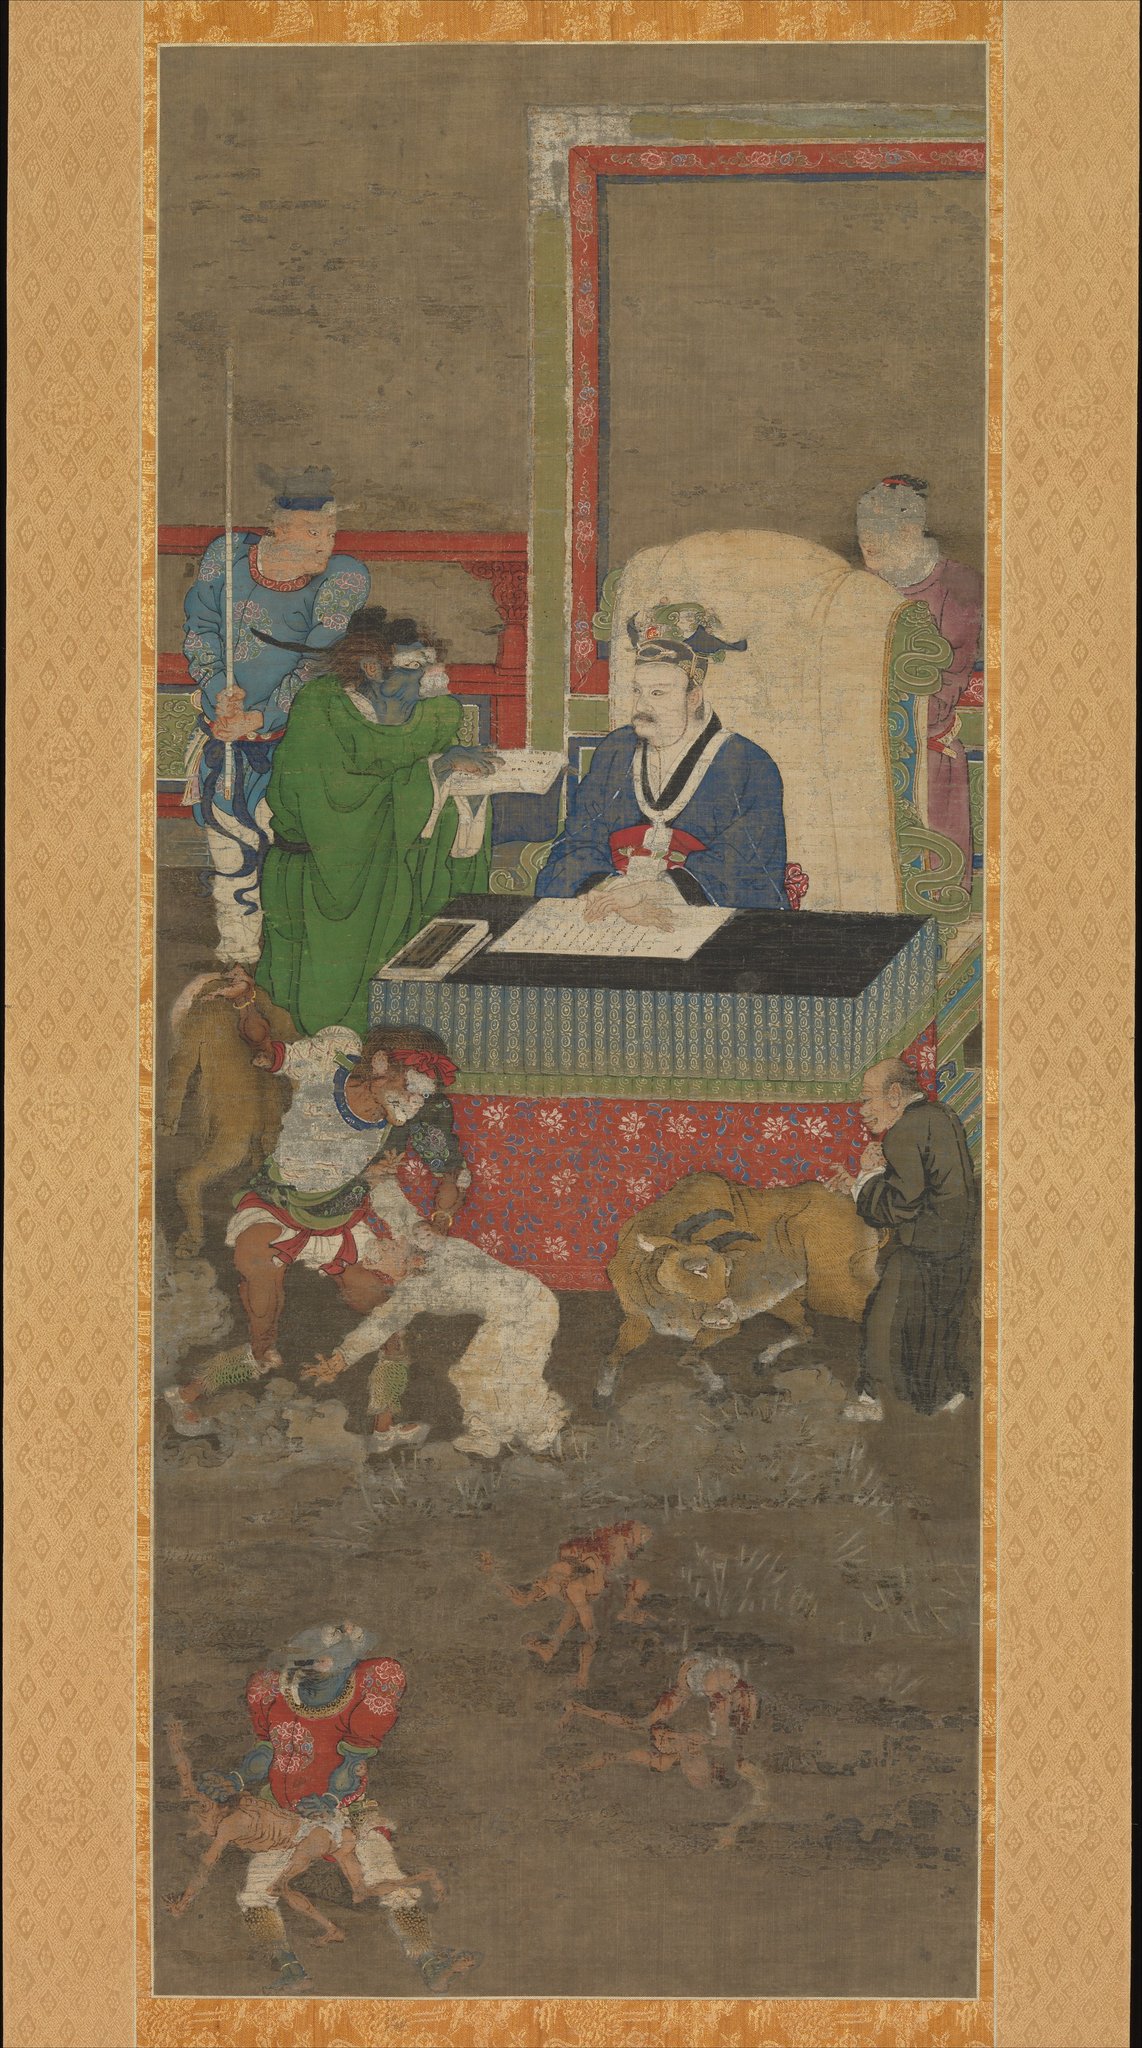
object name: hanging scroll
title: Ten Kings of Hell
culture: chinese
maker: jin chushi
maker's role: artist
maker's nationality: chinese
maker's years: 1167-1199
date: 1195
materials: ink, silk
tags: men,buffalos,demons,tables